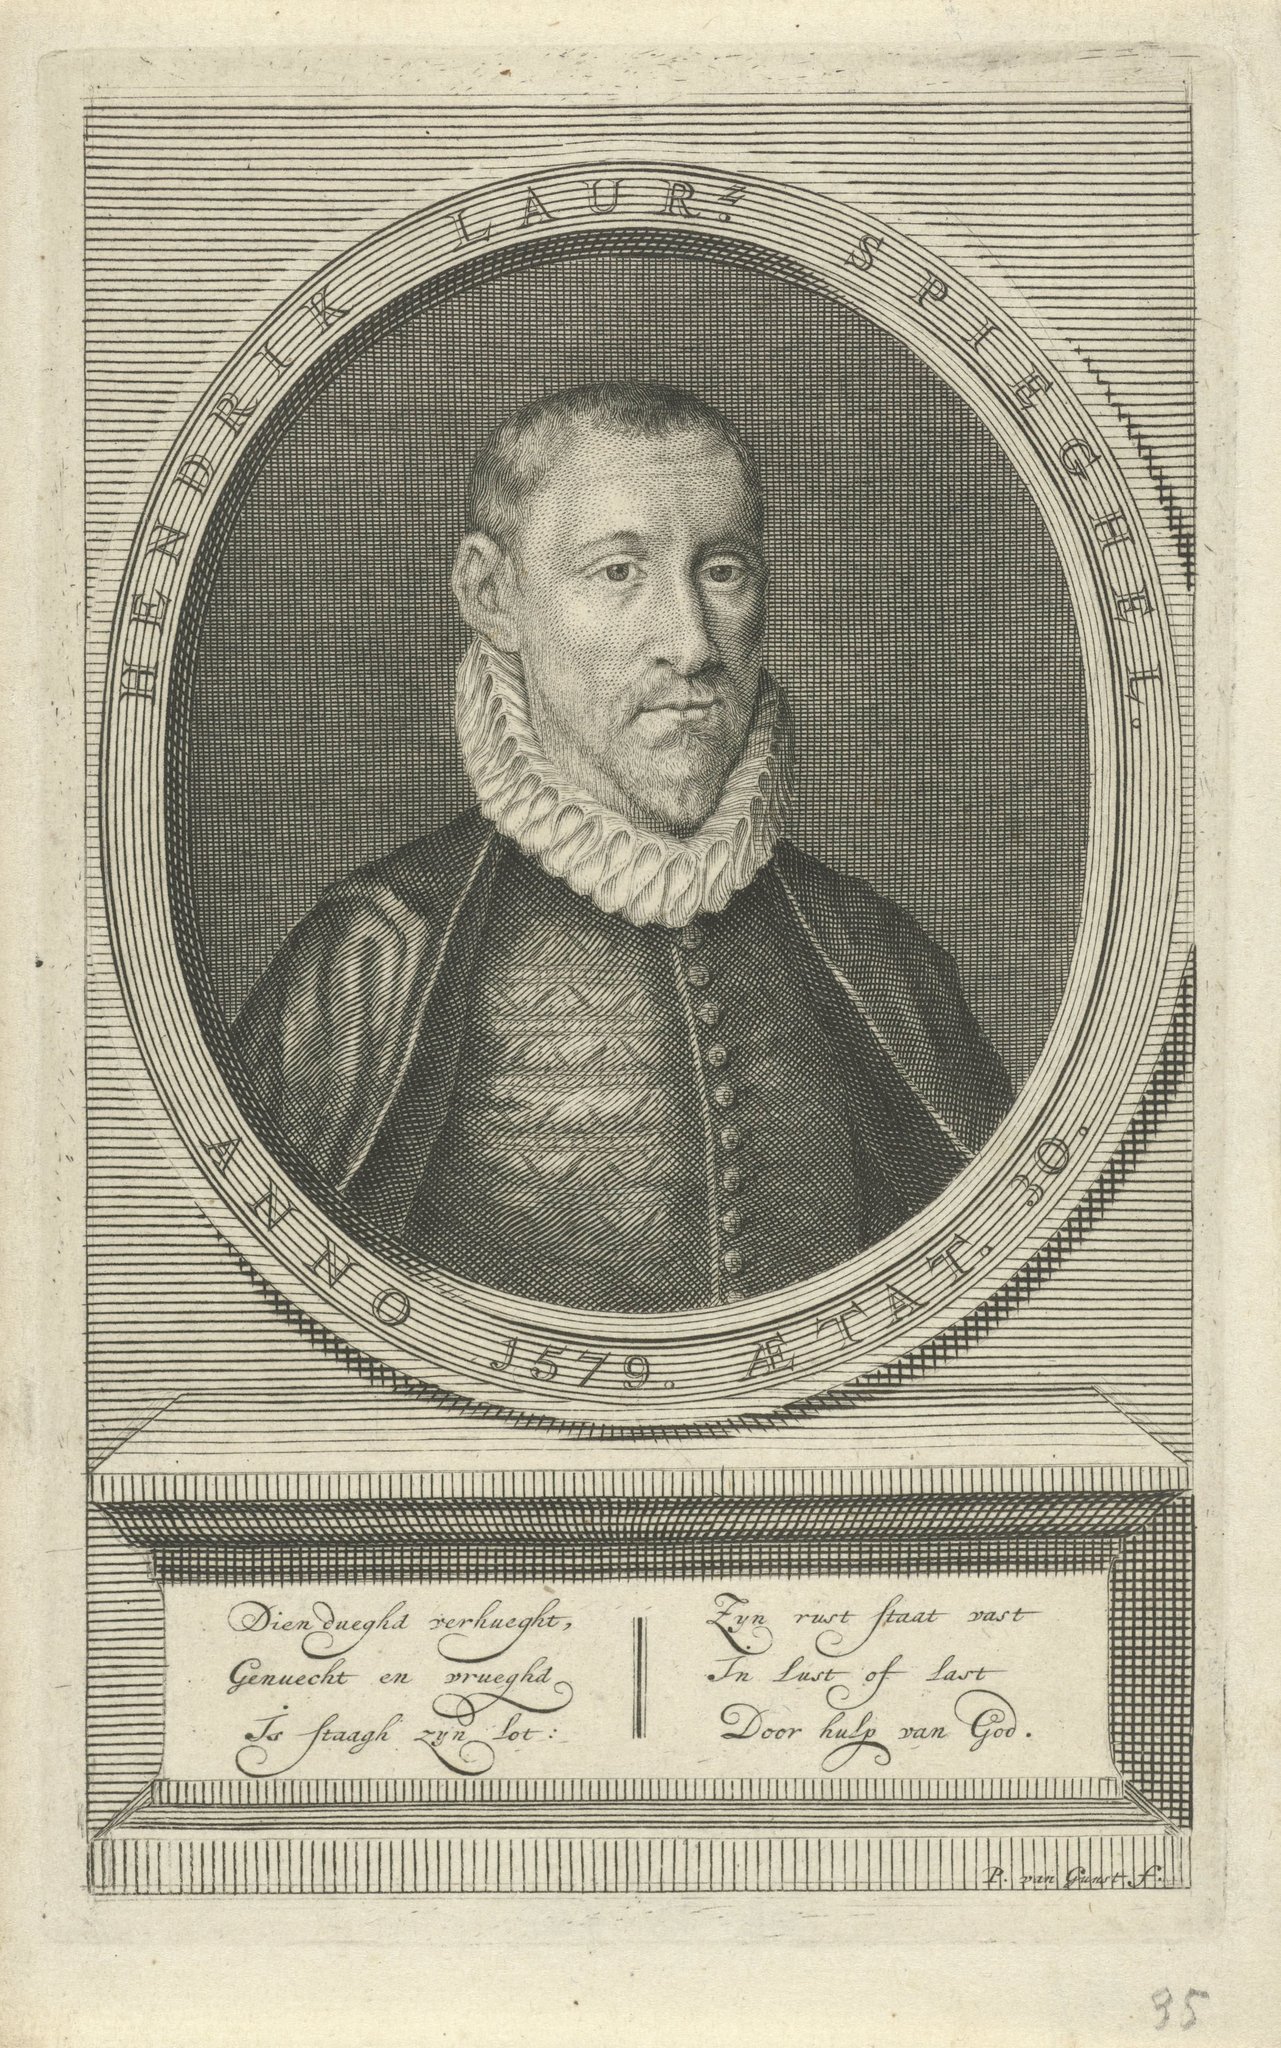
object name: print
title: Portret van Hendrik Laurensz. Spieghel op dertigjarige leeftijd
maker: pieter van gunst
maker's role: print maker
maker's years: 1658-1731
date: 1659-1731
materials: paper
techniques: engraving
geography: amsterdam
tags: amsterdam, hendrick laurensz. spieghel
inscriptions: collector's mark: Lugt 2228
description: Hendrik Laurensz. Spieghel, een Amsterdamse rederijker en handelaar, op dertigjarige leeftijd. Onder het portret een nederlands gedicht op zijn persoonlijk devies 'Dueghd verhuecht''.